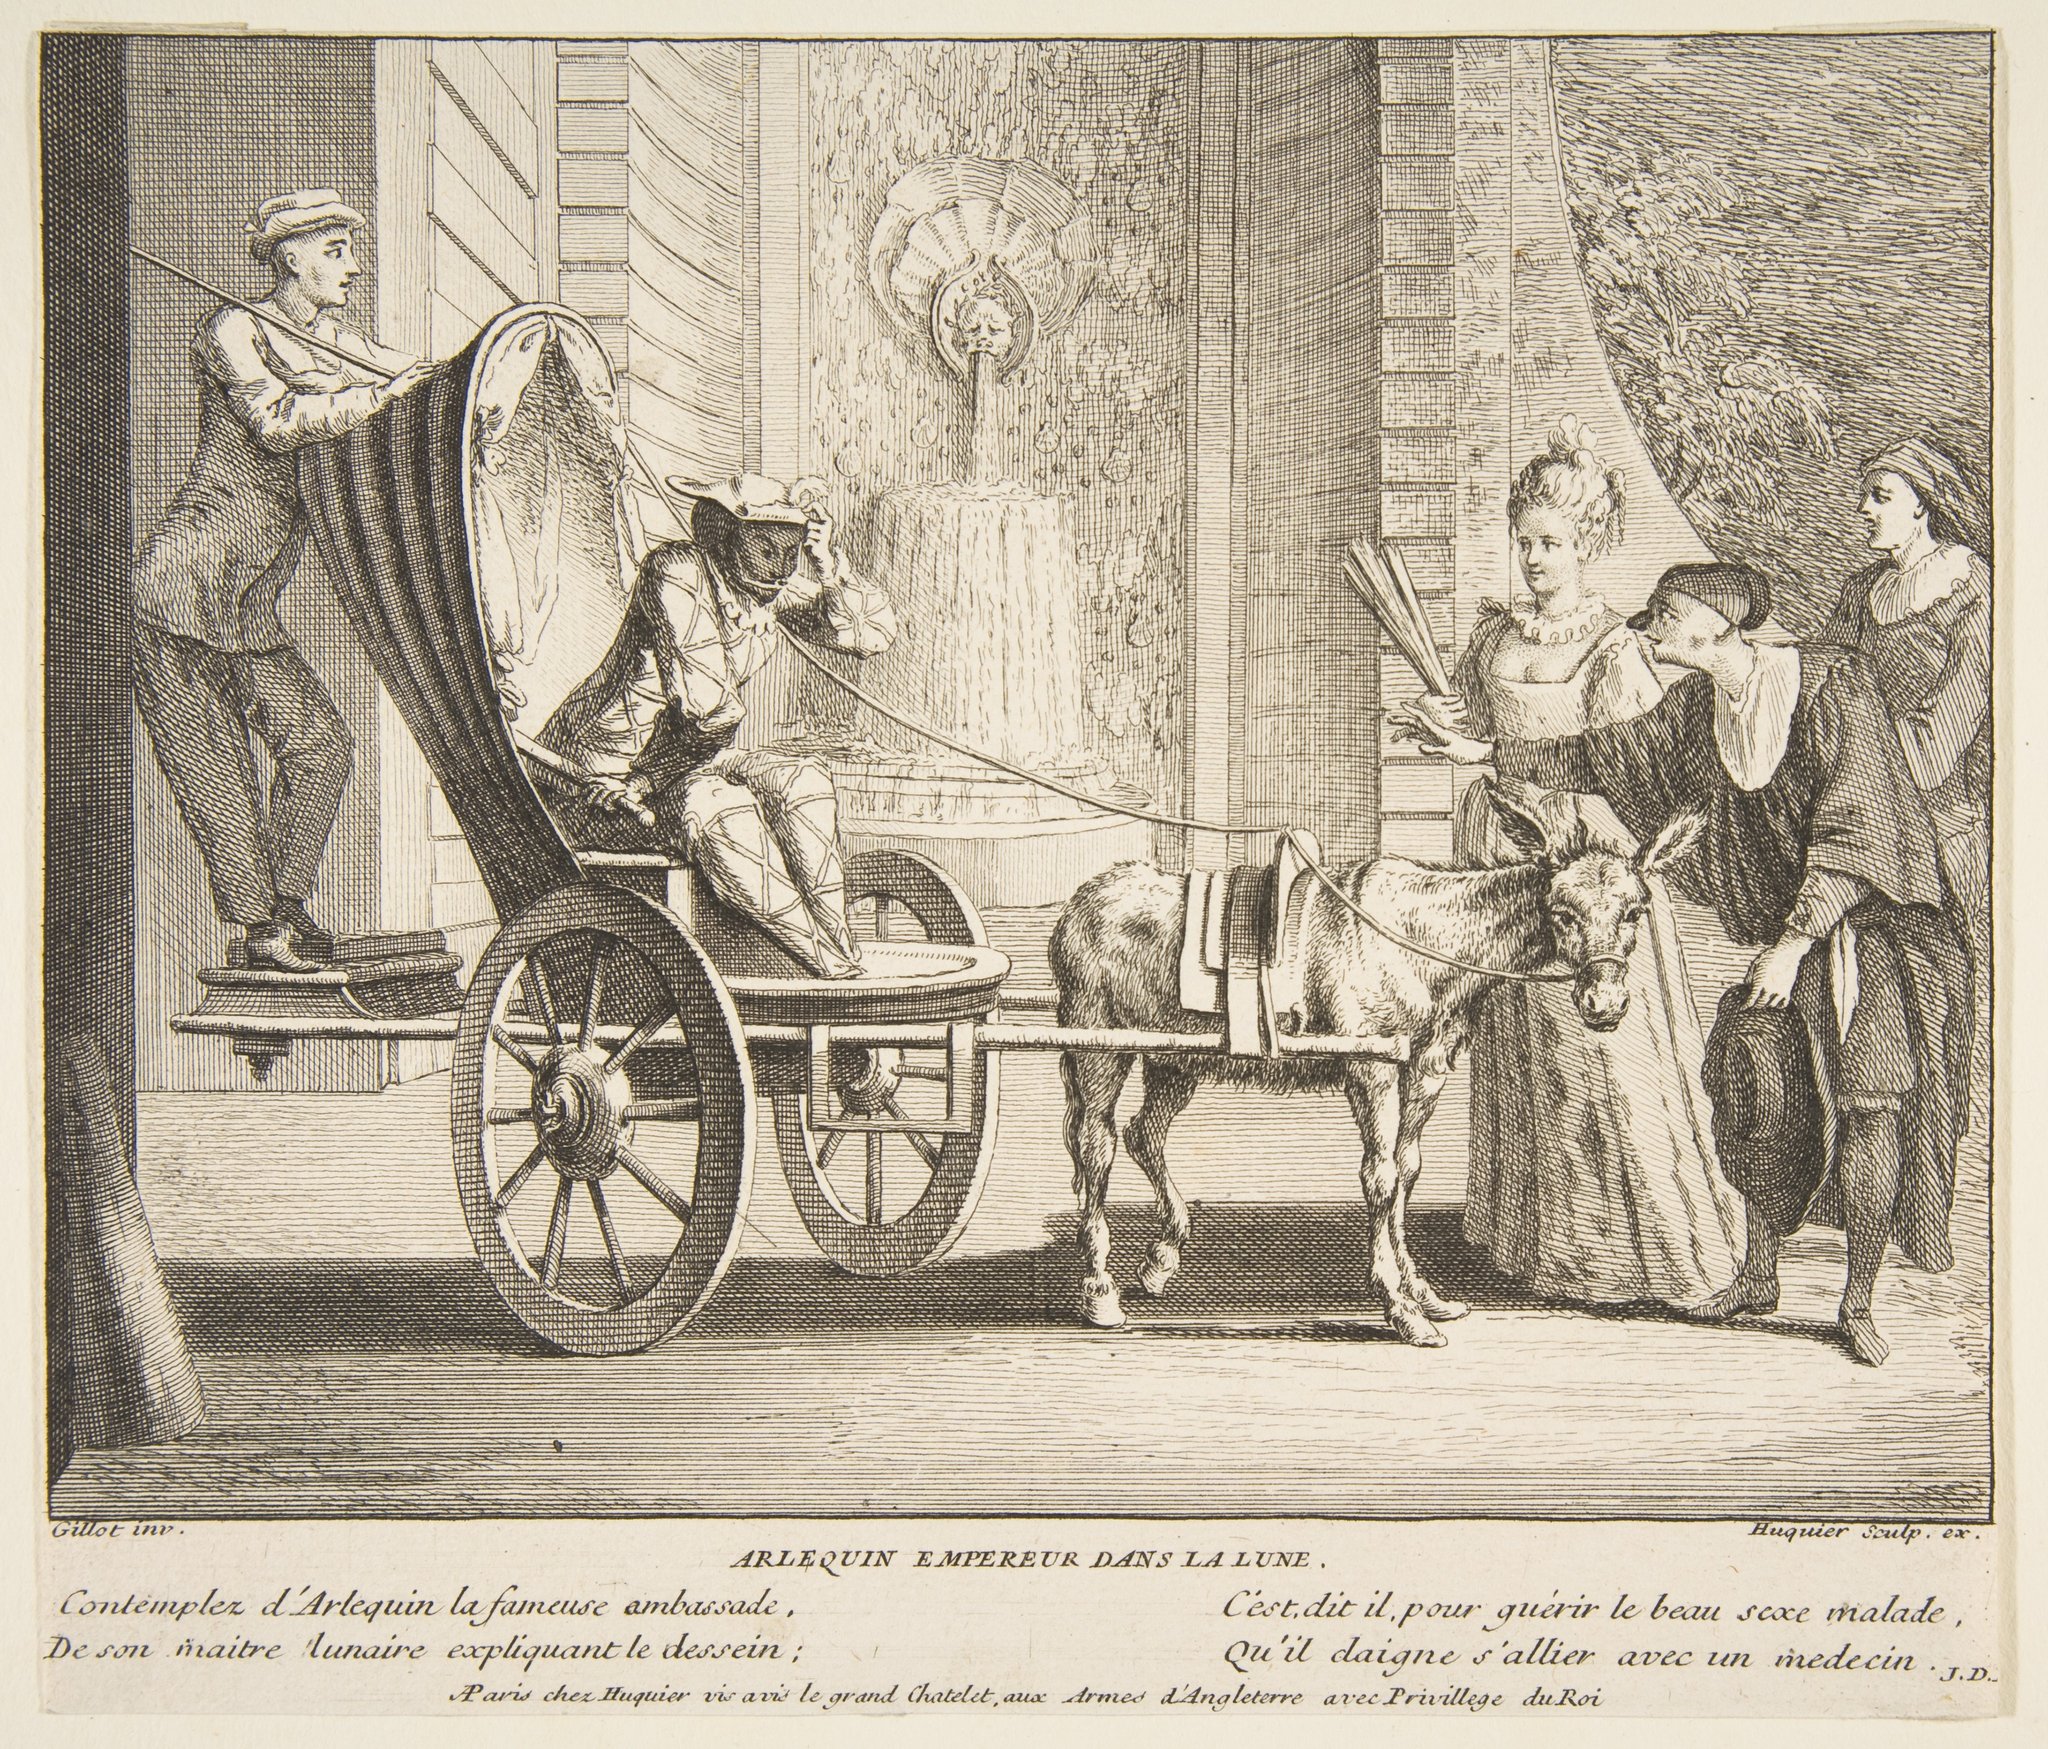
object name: print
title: Harlequin, Emperor on the Moon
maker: claude gillot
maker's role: artist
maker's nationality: french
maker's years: 1673-1722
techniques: etching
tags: men,women,donkeys,carriages